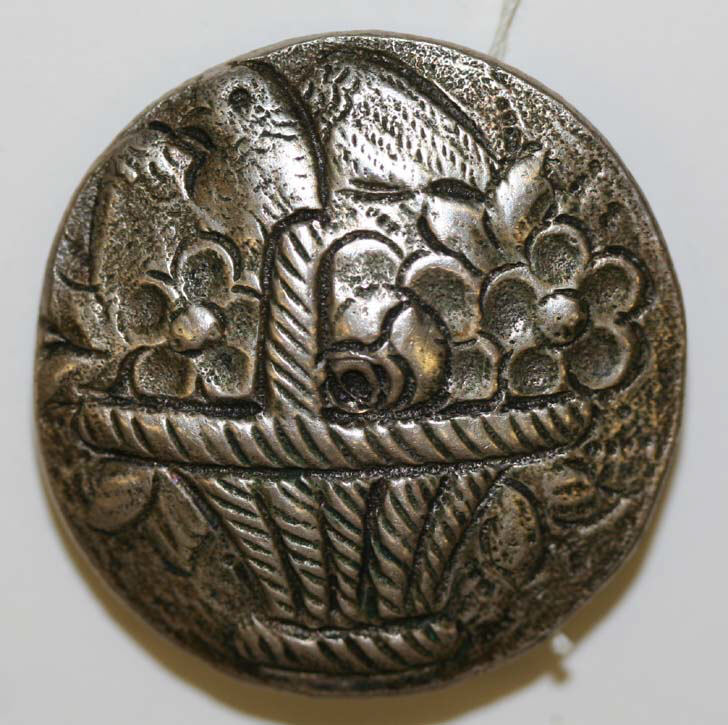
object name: button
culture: french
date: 1701-1800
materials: metal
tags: birds